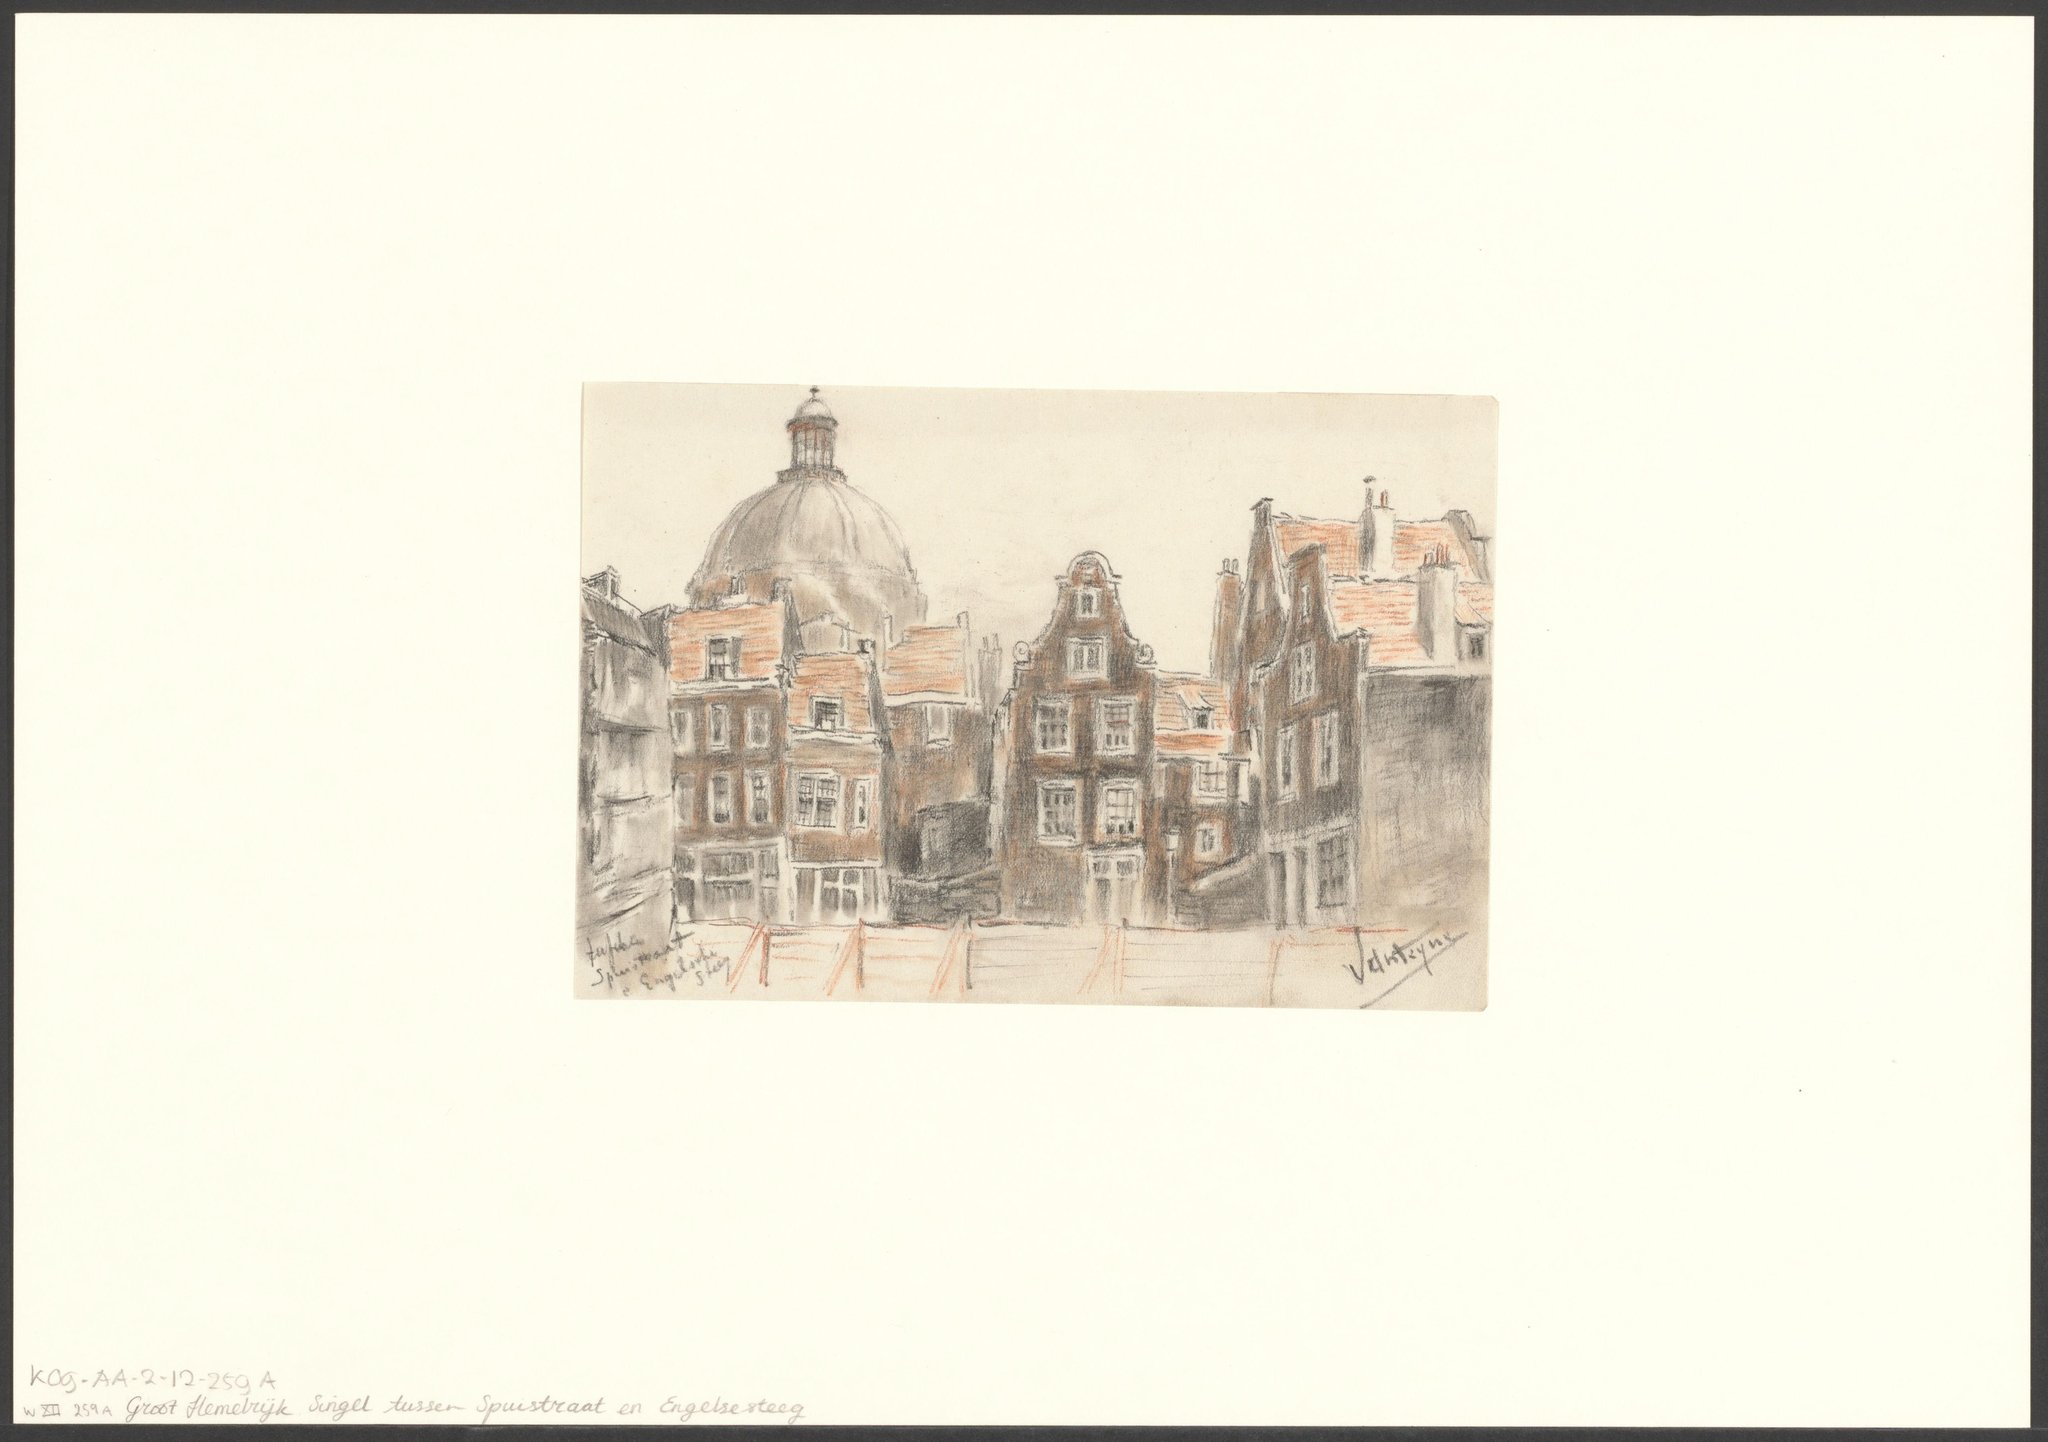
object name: drawing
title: Gezicht op het Groot Hemelrijk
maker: anthonie van teijn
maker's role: draughtsman, painter, print maker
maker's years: 1863-1943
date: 1873-1943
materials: chalk, paper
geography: amsterdam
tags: city-view, and landscape with man-made constructions, façade (of house or building)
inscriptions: inscription: ‘tussen / Spuistraat / en Engelsche / steeg’, inscription: ‘tussen Engelsche steeg / en Spuistraat’, signature: ‘VdTeyne’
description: Tekening binnen de Atlas Van Eck ingedeeld op wijknummer 12.